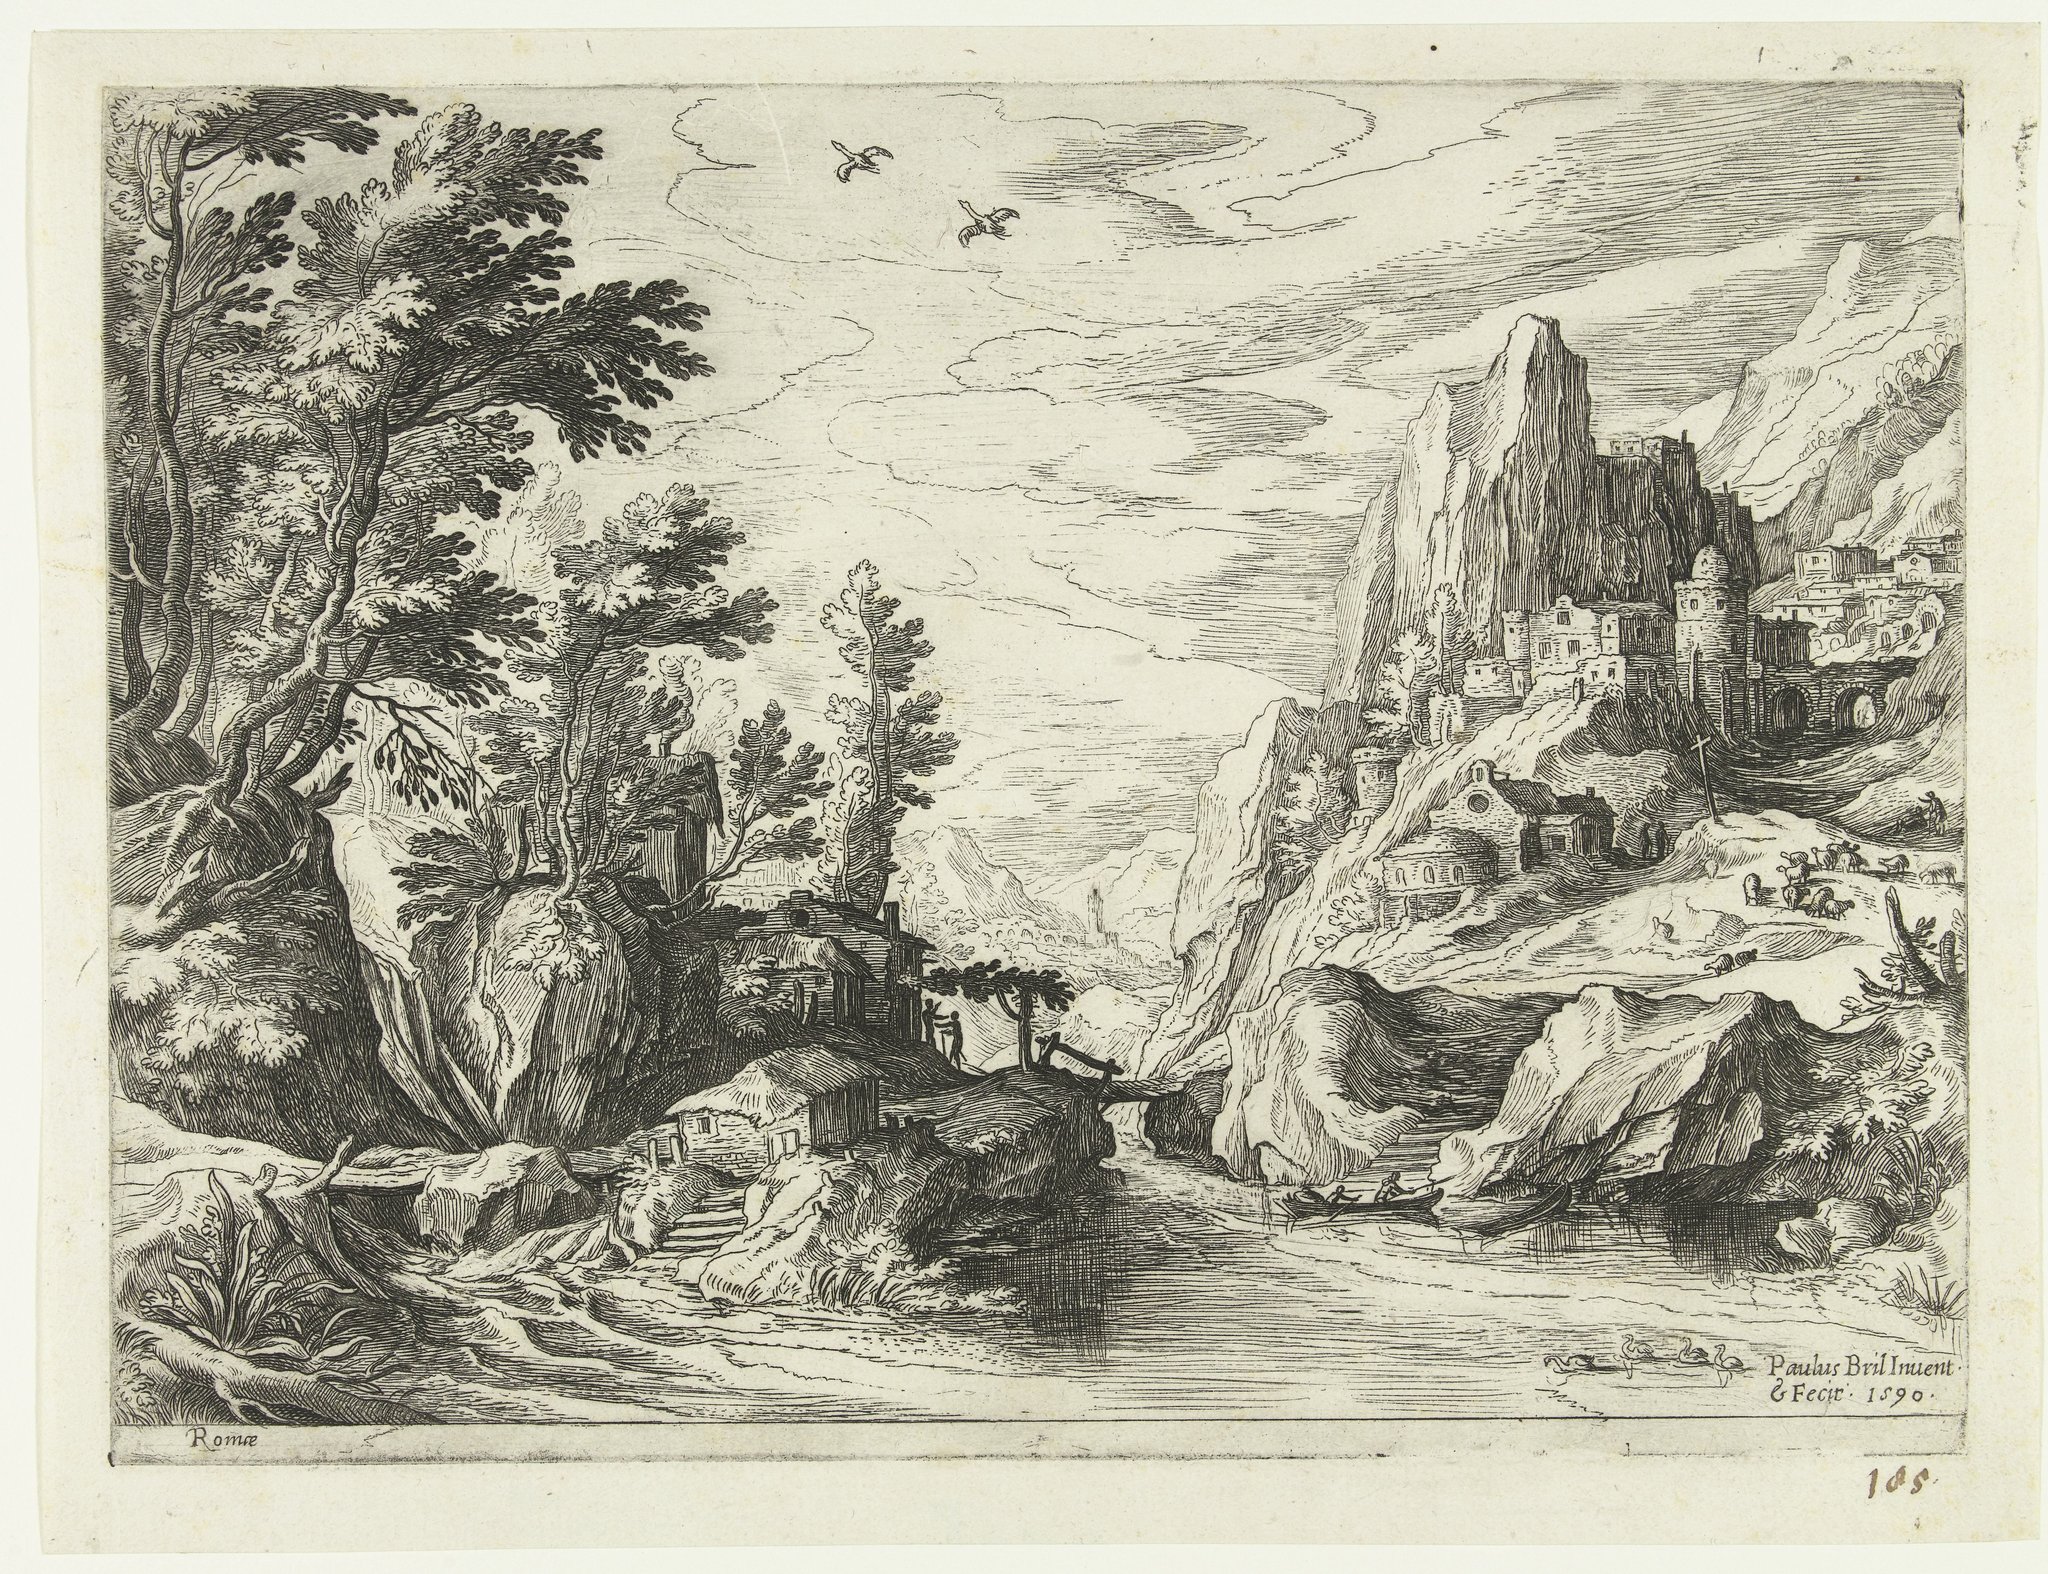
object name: print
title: Rivierlandschap in Campania met stad op rotsen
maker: paul bril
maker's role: draughtsman, print maker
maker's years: 1554-1626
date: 1590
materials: paper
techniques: etching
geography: rome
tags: rocky coast, campania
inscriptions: collector's mark: Lugt 2228a, caption: ‘Romae’